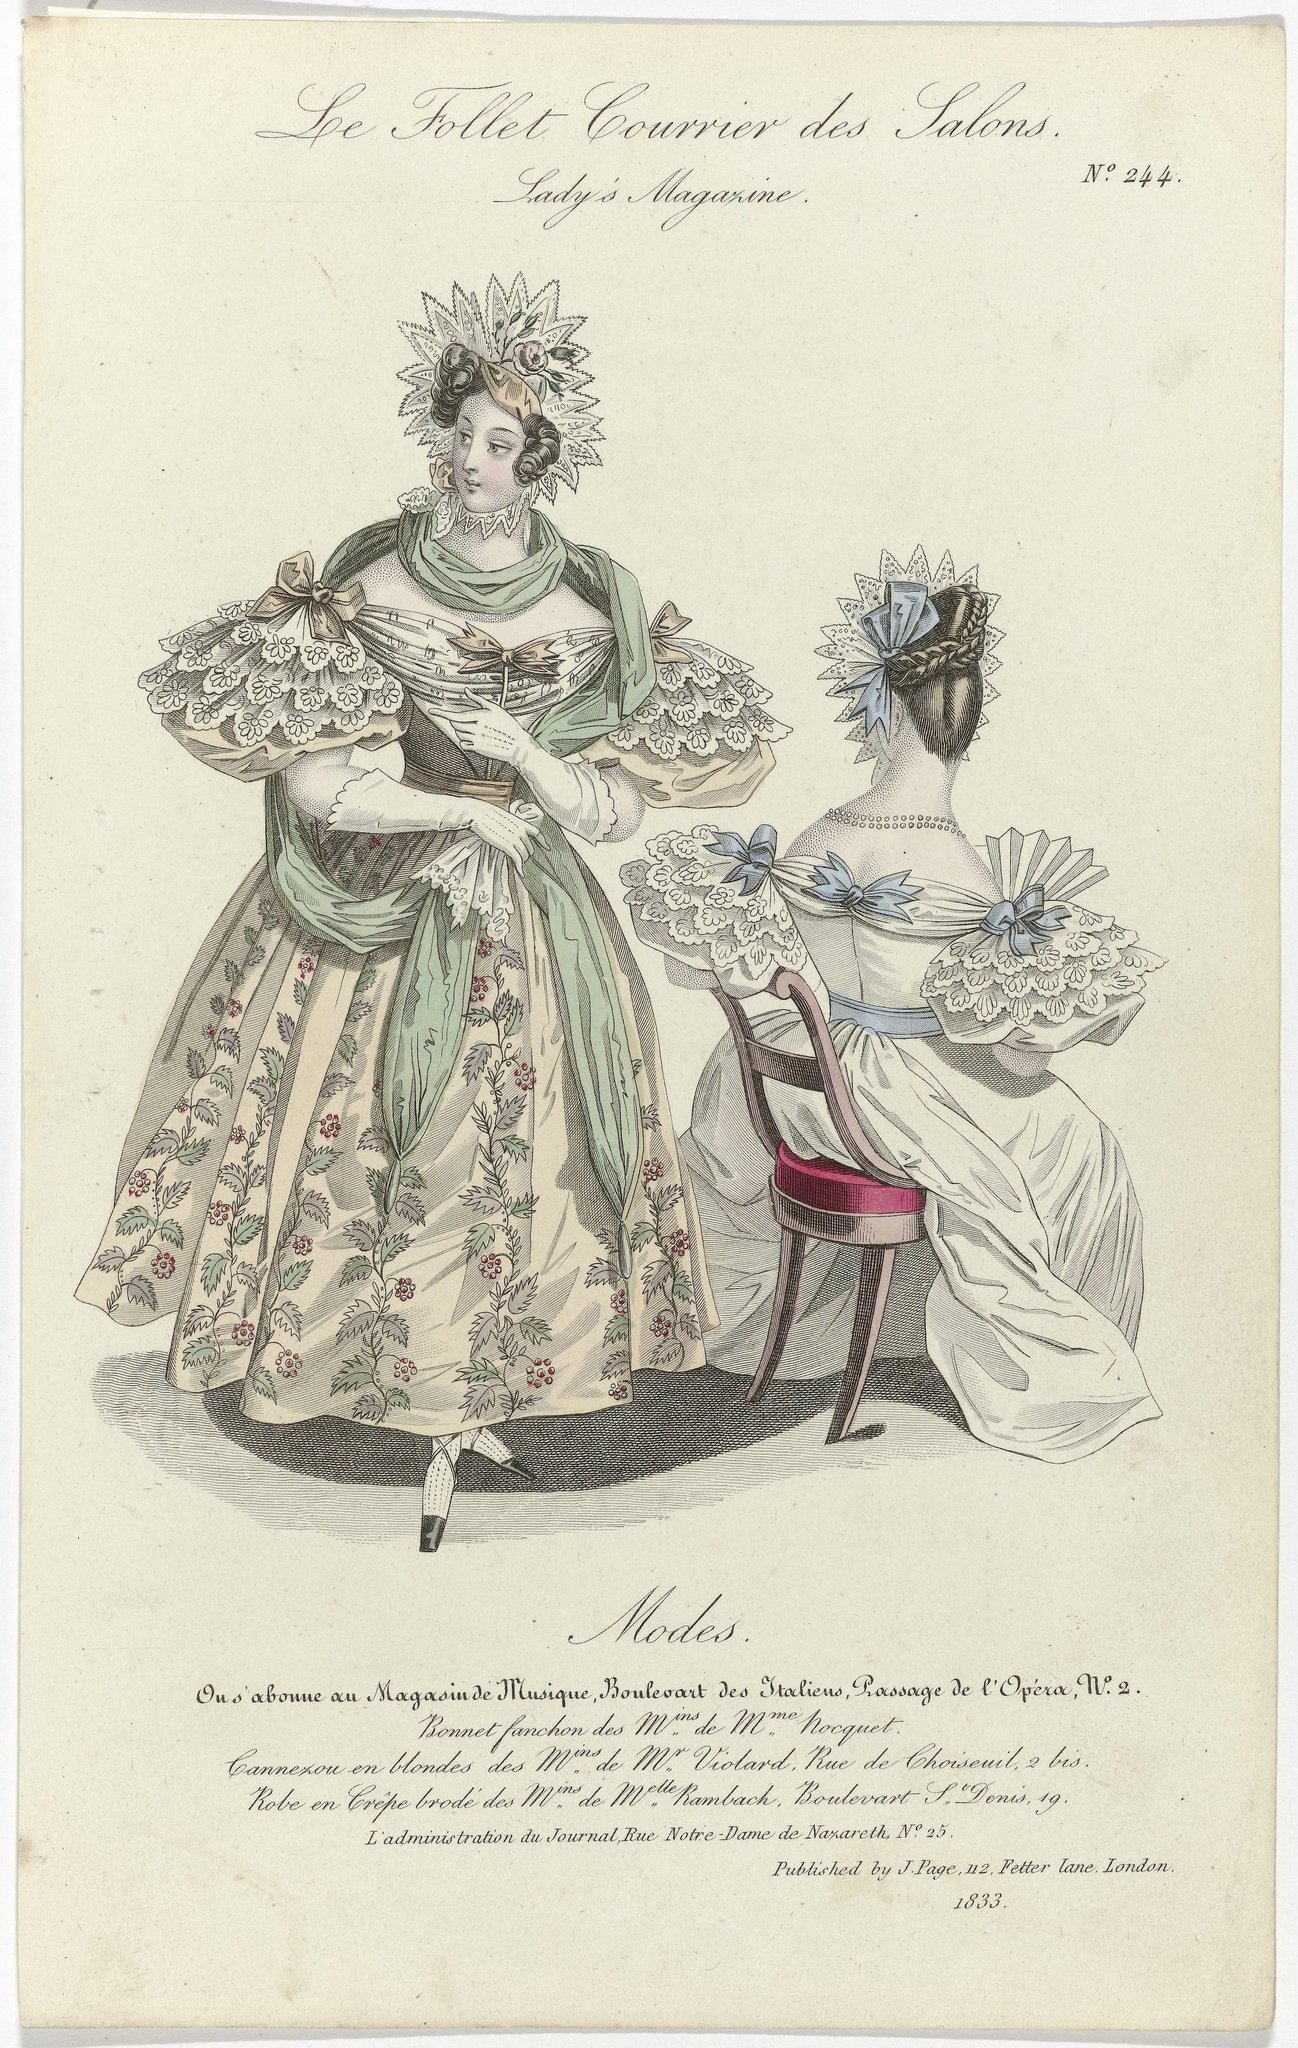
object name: fashion print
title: Le Follet Courrier des Salons, Lady's Magazine, 1833, No. 244: Bonnet fanchon (...)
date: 1833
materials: paper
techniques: engraving, hand coloring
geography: london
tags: handkerchief (+ women's clothes), gloves, mittens (long gloves) (+ women's clothes), embroidery (ornamentation) (+ women's clothes), head-gear (fanchon) (+ women's clothes), clothing for the upper part of the body: blouse (+ lace used for clothes), head-gear: cap (+ women's clothes), fashion plates, dress, gown (+ women's clothes), shoes, sandals, stockings, socks (+ women's clothes), necklace (+ women's clothes)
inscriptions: title: ‘Le Follet Courrier des Salons. Lady's Magazine.’, address: ‘On s'abonne au Magasin de Musique, Boulevart des Italiens, Passage de l'Opèra, No. 2. / L'administration du Journal, Rue Notre-Dame de Nazareth, No. 25. / Published by J. Page, 112, Fetter lane. London.’, caption: ‘Modes. / Bonnet fanchon des M'ins de M"me Hocquet. Cannezou en blondes des M"ins de M"r Violard, Rue de Choiseuil, 2 bis. Robe en Crêpe brodé des M"ins de M"elle Rambach, Boulevart S"t Denis, 19.’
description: Vrouw met op het hoofd een 'bonnet fanchon' met gekartelde zoom uit de winkels van Hocquet. 'Canezou' van Blonde (kloskant) uit de winkels van Violard. Japon van geborduurde crêpe uit de winkels van Rambach. Verdere accessoires: sjaal, collier, lange handschoenen, zakdoek, schoenen met gekruiste banden en vierkante neuzen (cothurnes). Zittende figuur in eenzelfde japon, op de rug gezien. Prent uit het modetijdschrift Le Follet Courrier des Salons (novembre 1829- octobre 1882).